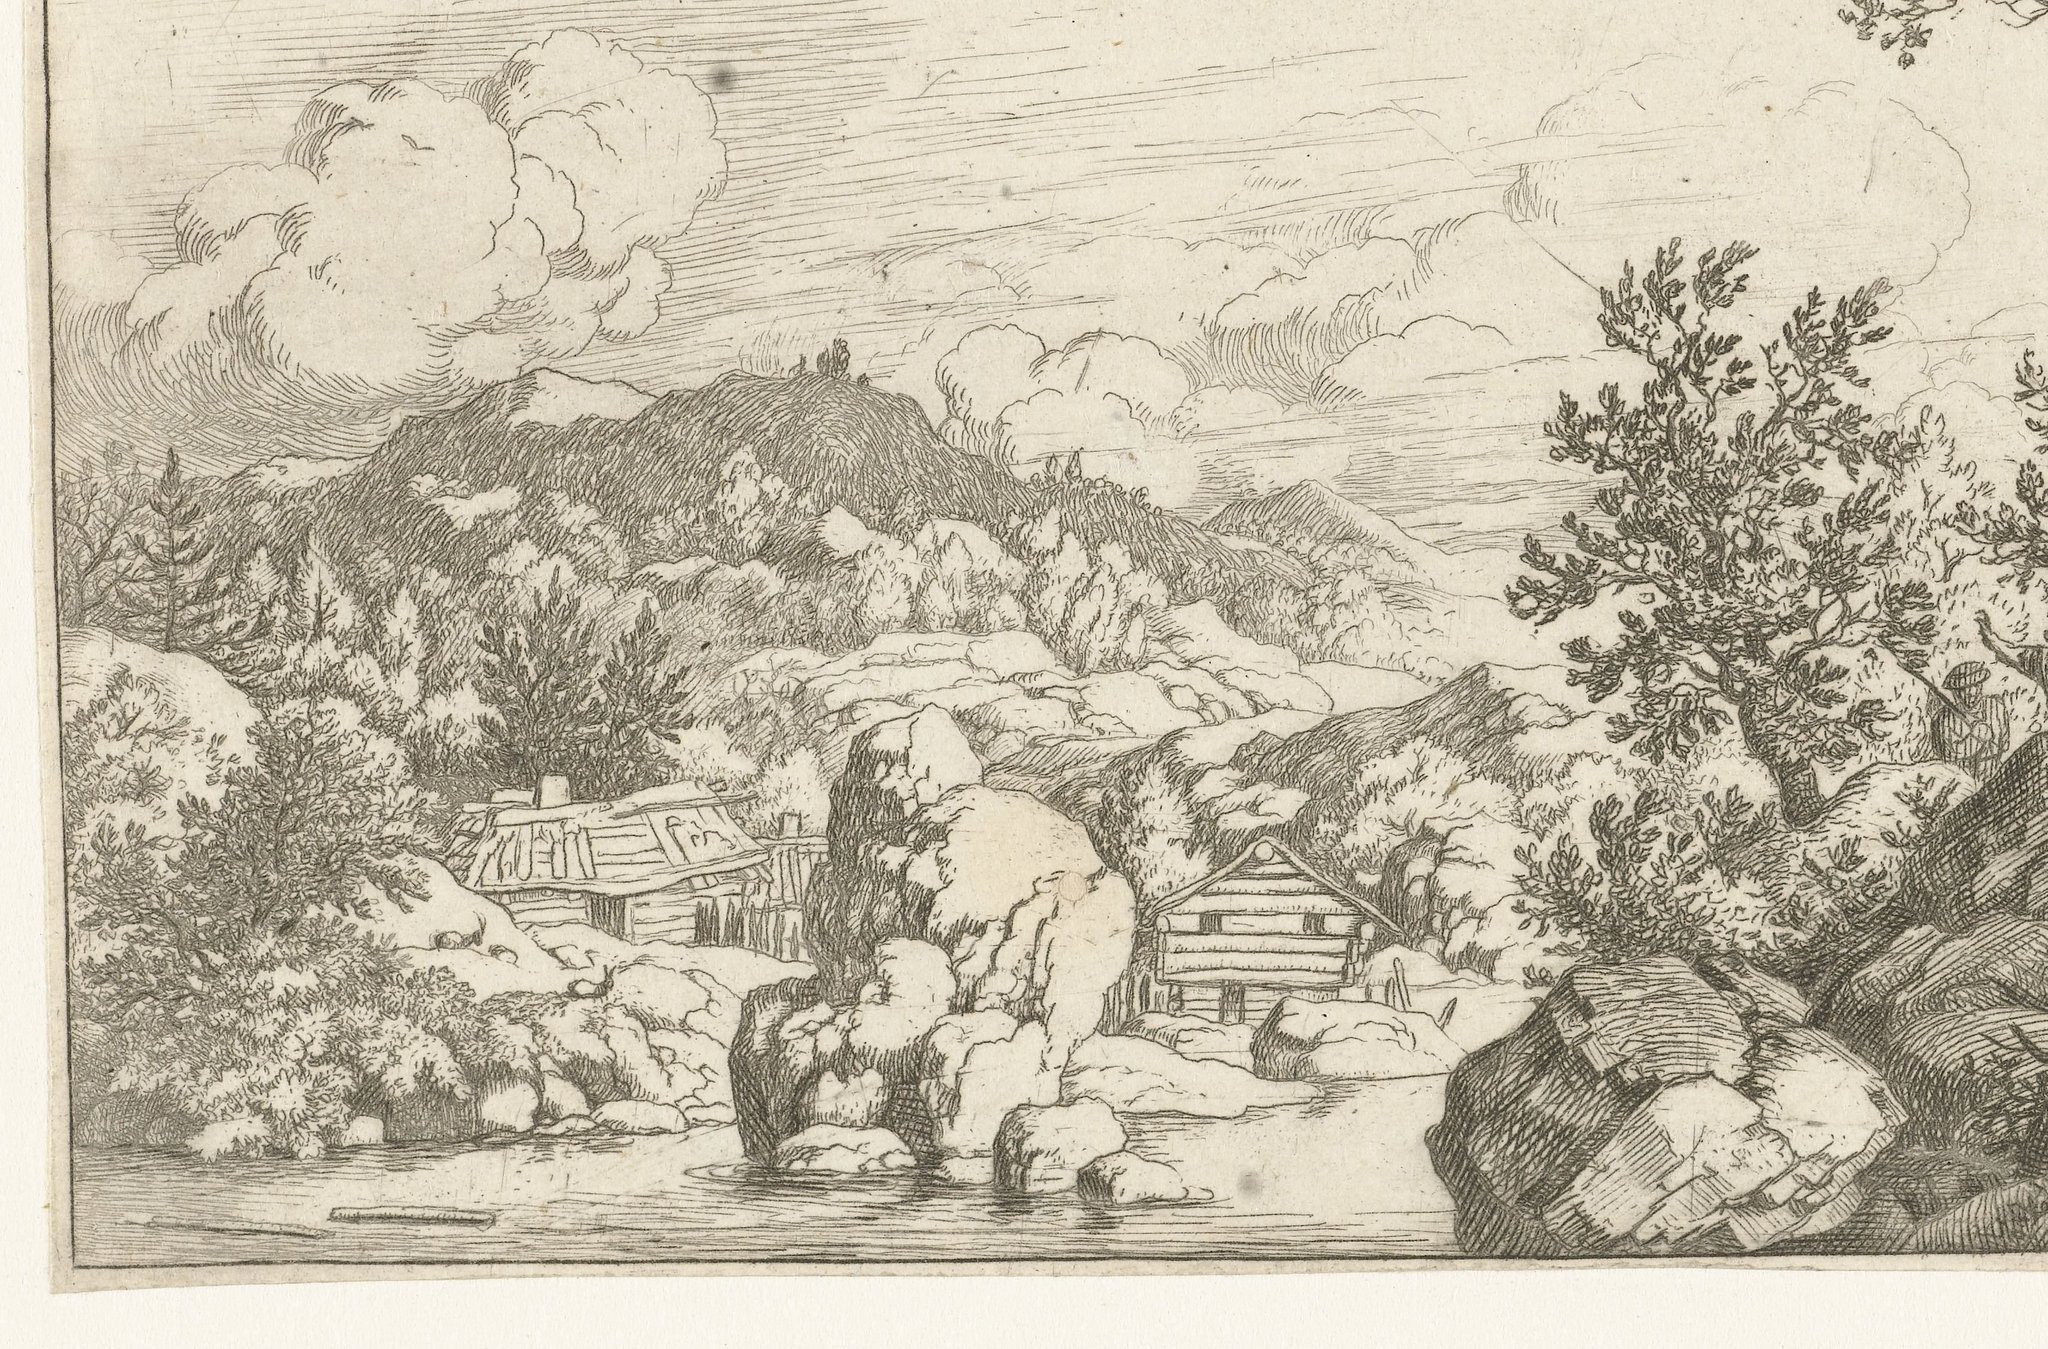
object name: print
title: Landschap met rots in een rivier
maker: allaert van everdingen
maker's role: draughtsman, painter, print maker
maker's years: 1621-1675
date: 1631-1675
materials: paper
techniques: etching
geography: netherlands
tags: river (+ landscape with figures, staffage)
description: Berglandschap met een rivier rondom een grote rots en op de oever enkele houten huizen. Tussen de bomen en rotsen op de voorgrond twee personen.